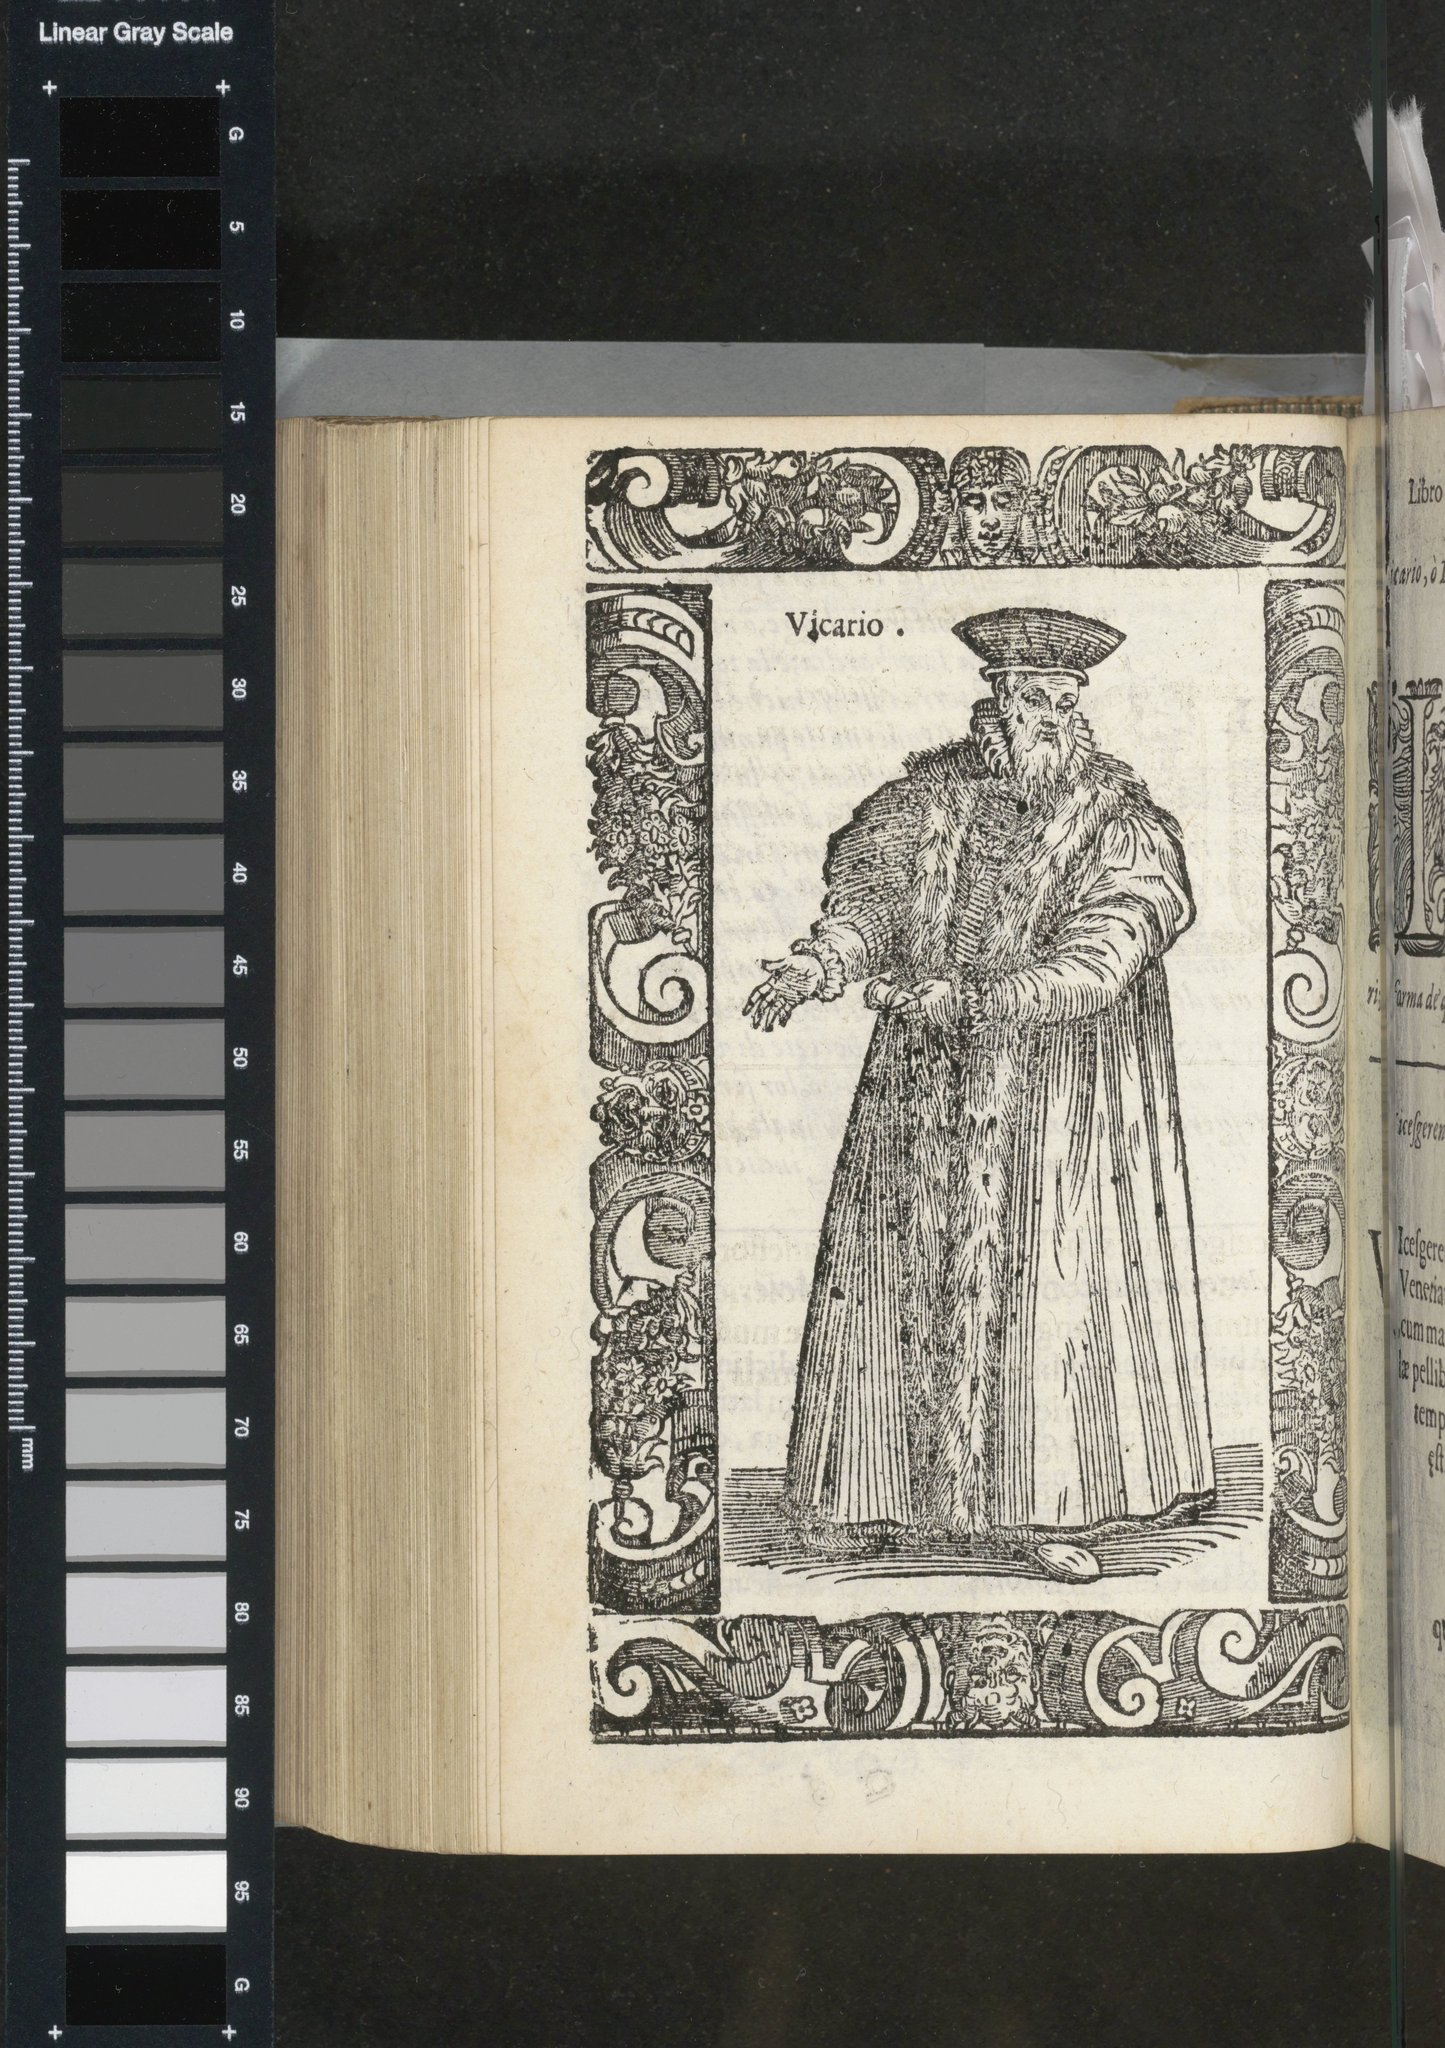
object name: costume print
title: Vicario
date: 1598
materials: paper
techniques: woodcut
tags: fashion plates